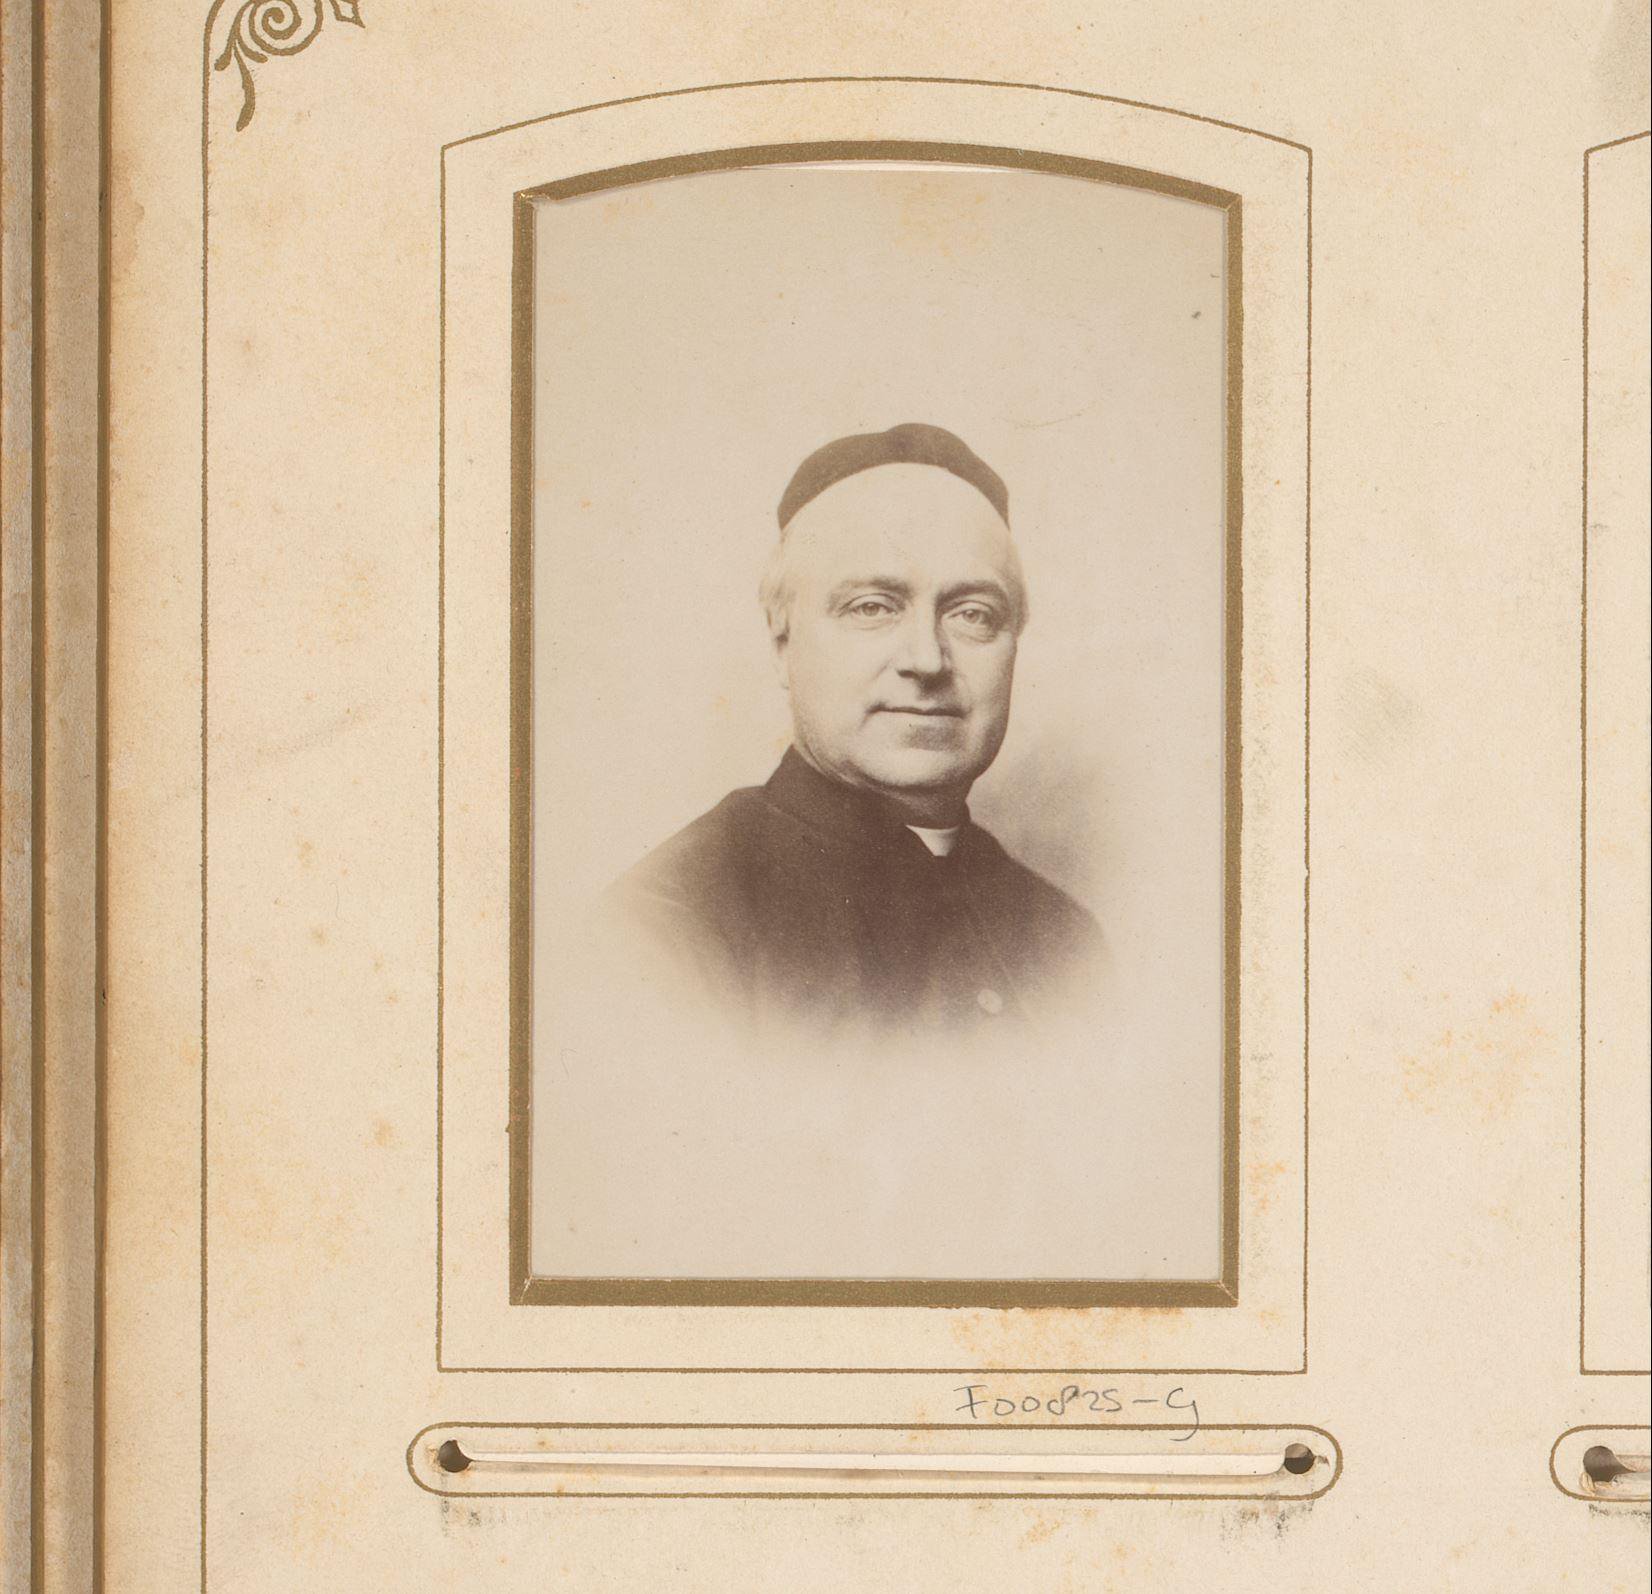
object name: photograph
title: Portret van een geestelijke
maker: johannes wilhelmus franciscus offenberg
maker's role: fotograaf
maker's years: 1839-1919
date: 1877-1888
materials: cardboard, photographic support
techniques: albumen print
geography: amsterdam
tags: theologian, historical persons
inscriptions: inscription: ‘OFFENBERG/ PHOTOGRAPHIE/ DE S.M. LA REINE DES PAYS BAS/ DAMSTRAAT/ AMSTERDAM./ (...)’